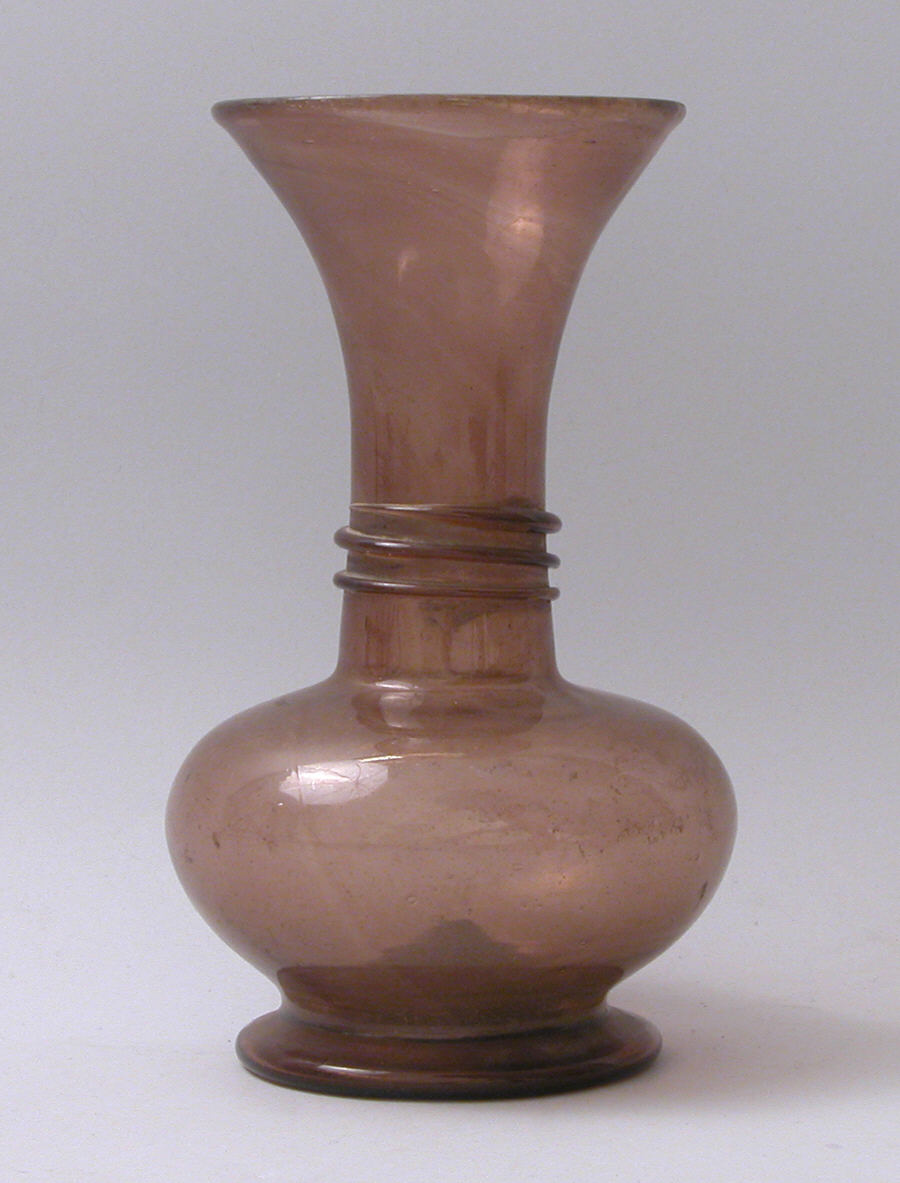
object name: vase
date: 1701-1900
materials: glass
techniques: glassblowing, tooling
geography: iran